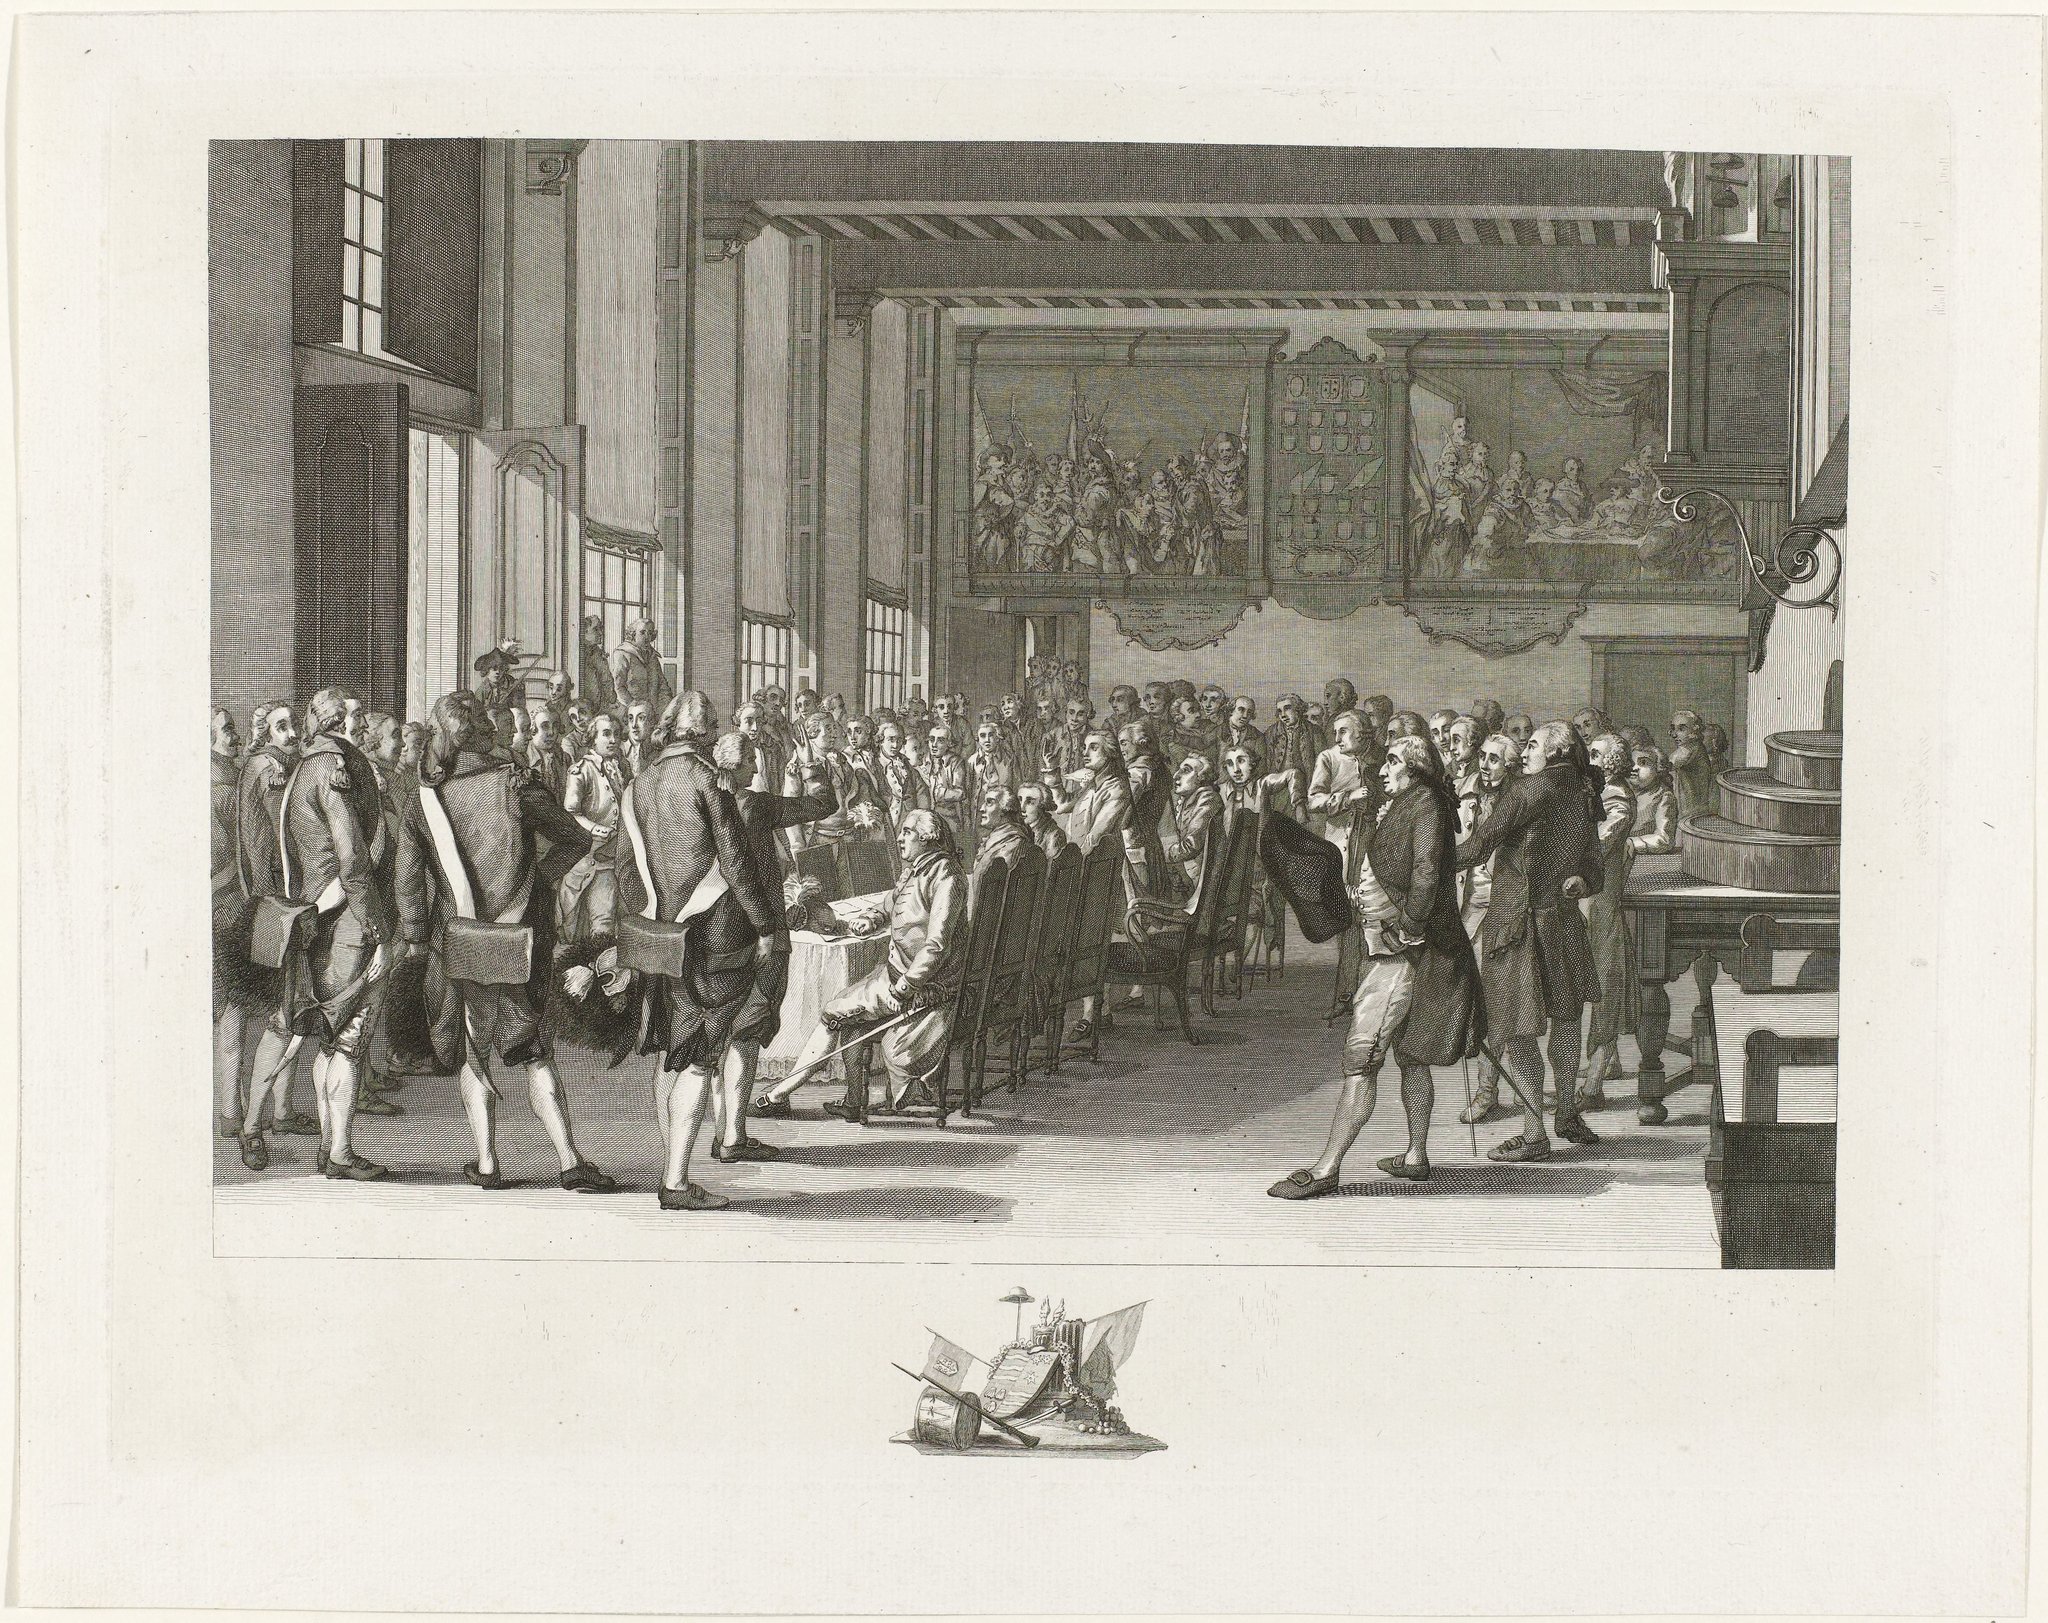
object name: print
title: Beëdiging van het genootschap Pro Aris et Focis te Haarlem, 1787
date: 1787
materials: paper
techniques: engraving, etching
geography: northern netherlands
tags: taking the oath ~ military service, haarlem, patriots (1780-1795)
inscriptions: collector's mark: Lugt 2228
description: Interieur van de Oude Doelen te Haarlem met de beëdiging van het Genootschap Pro Aris et Focis als een van de drie bataljons van de Haarlemse schutterij, 5 april 1787. Aan de muur handen twee schutterstukken.